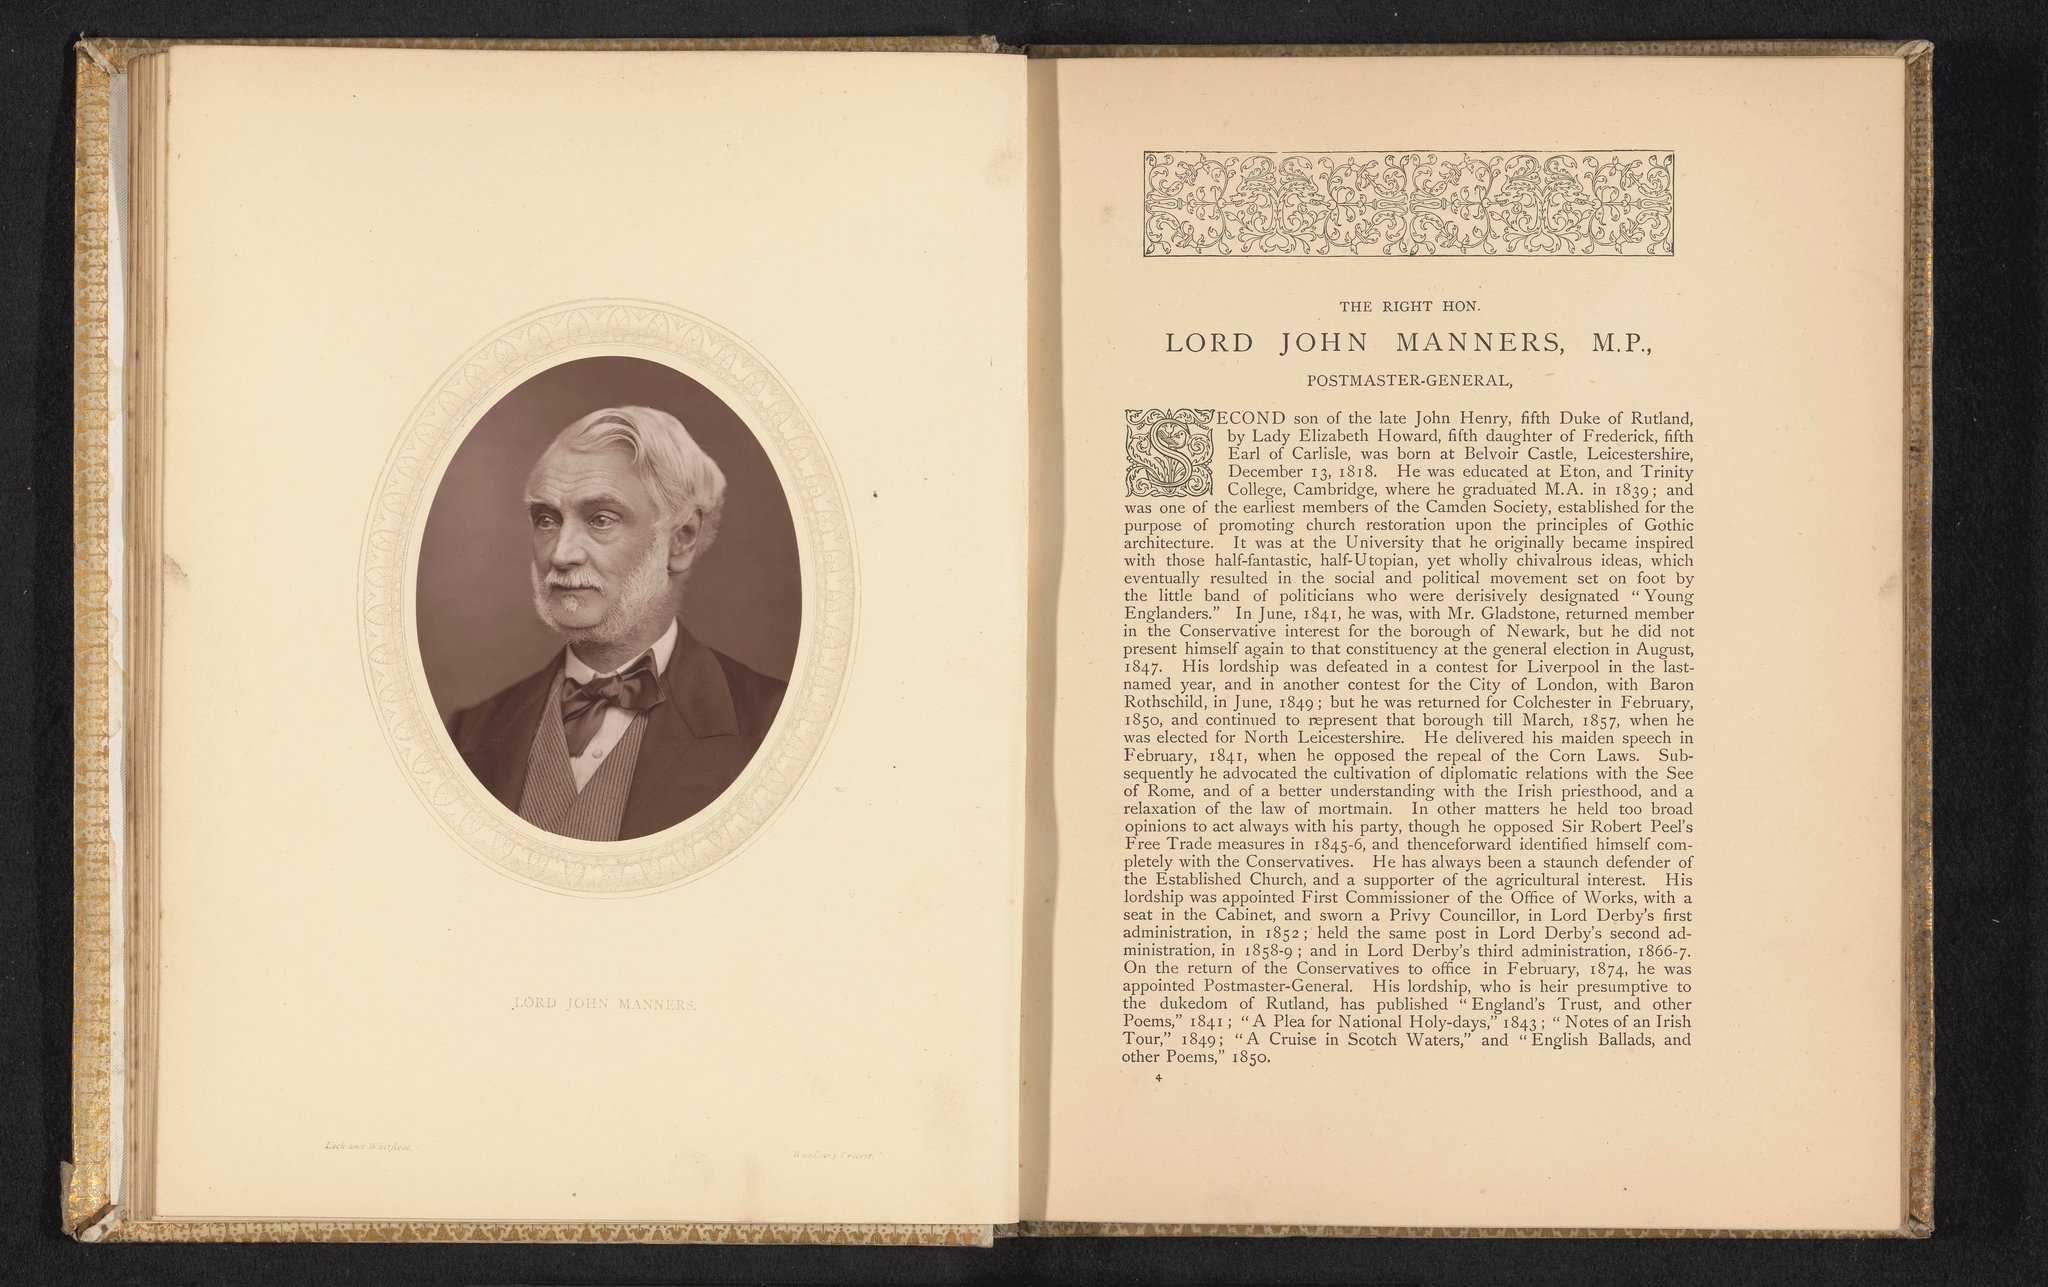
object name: page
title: Lord John Manners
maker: Anonymous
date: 1873-1878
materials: paper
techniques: woodburytype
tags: historical persons (portraits and scenes from the life) (+ (full) bust portrait), politician, e.g. party leader